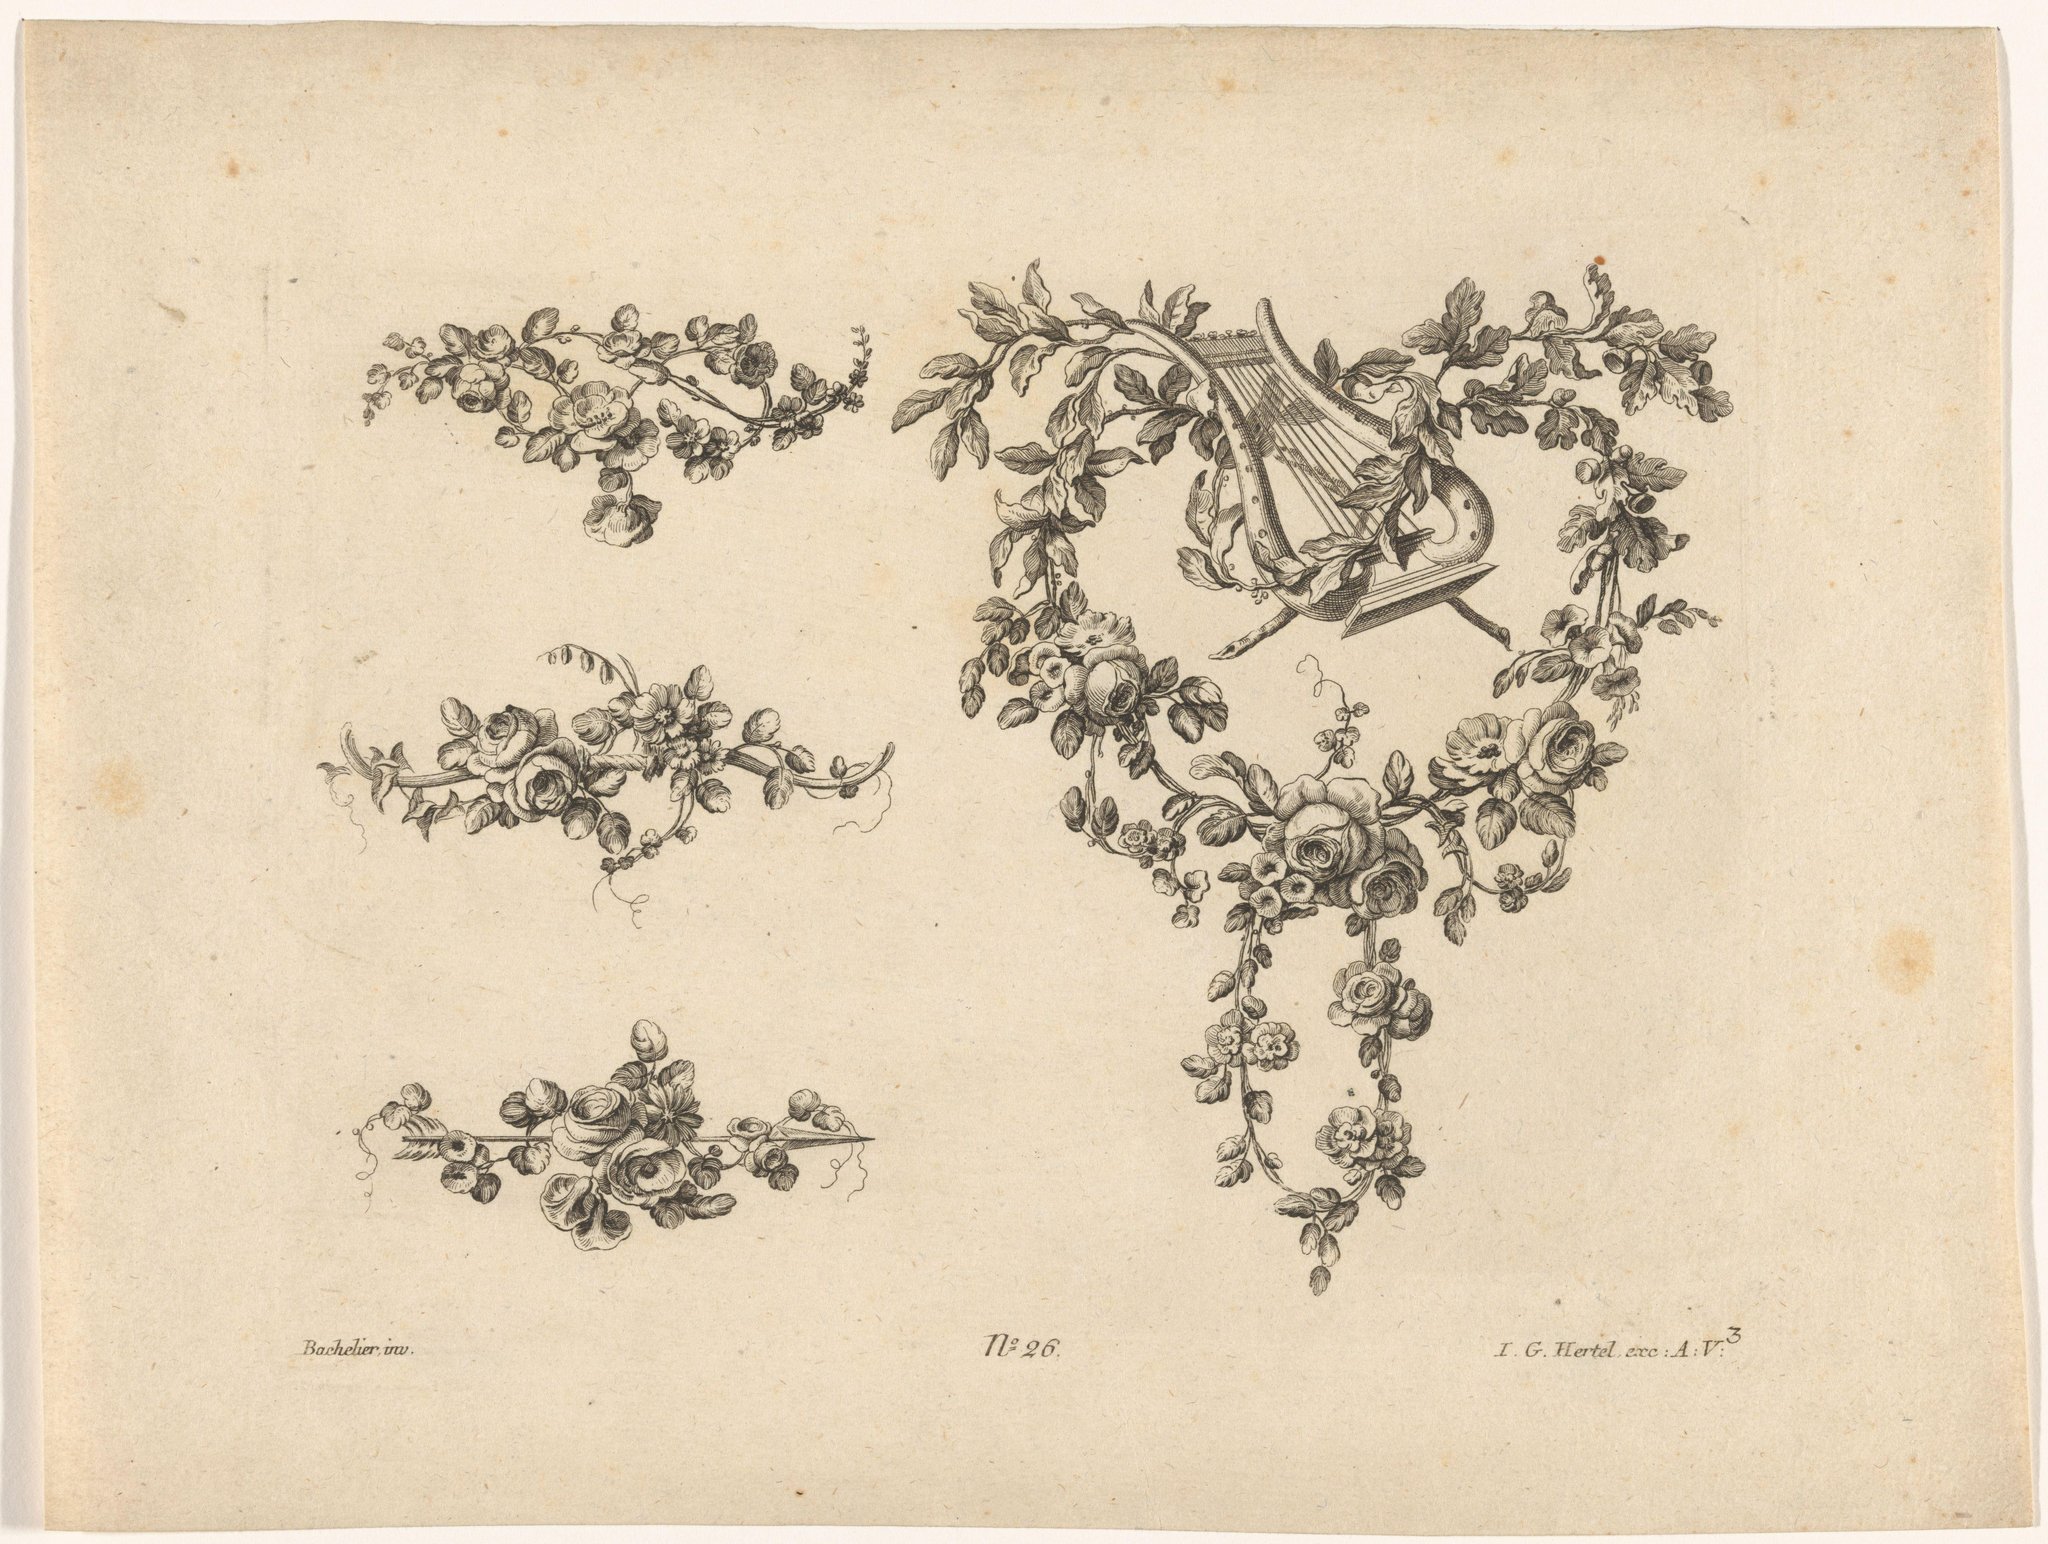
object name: ornament print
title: Ontwerpen voor bloemschikkingen met lier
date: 1760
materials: paper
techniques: engraving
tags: ornaments ~ art, lyre, cithara, psaltery, flowers ~ ornament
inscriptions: collector's mark: Lugt 2228, number: ‘No 26’, signature: ‘I.G. Hertel exc. A:V:3’, collector's mark: Lugt 2760, signature: ‘Bachelier inv.’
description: In Katalog der Ornamentstich-Sammlung der Staatlichen Kunstbibliothek Berlin wordt vermeld dat dit blad onderdeel is van een tweede uitgave en een tegendruk is van de eerste uitgave.